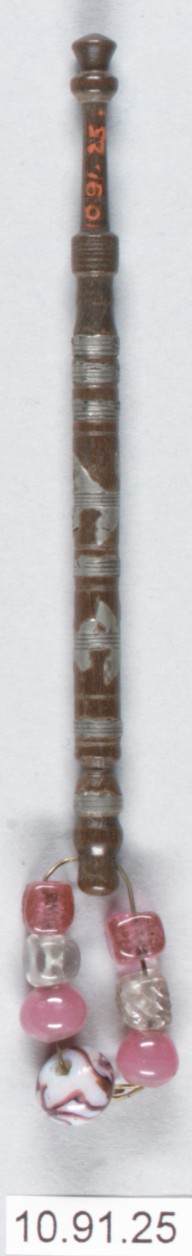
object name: bobbin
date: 1801-1900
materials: metal, wood